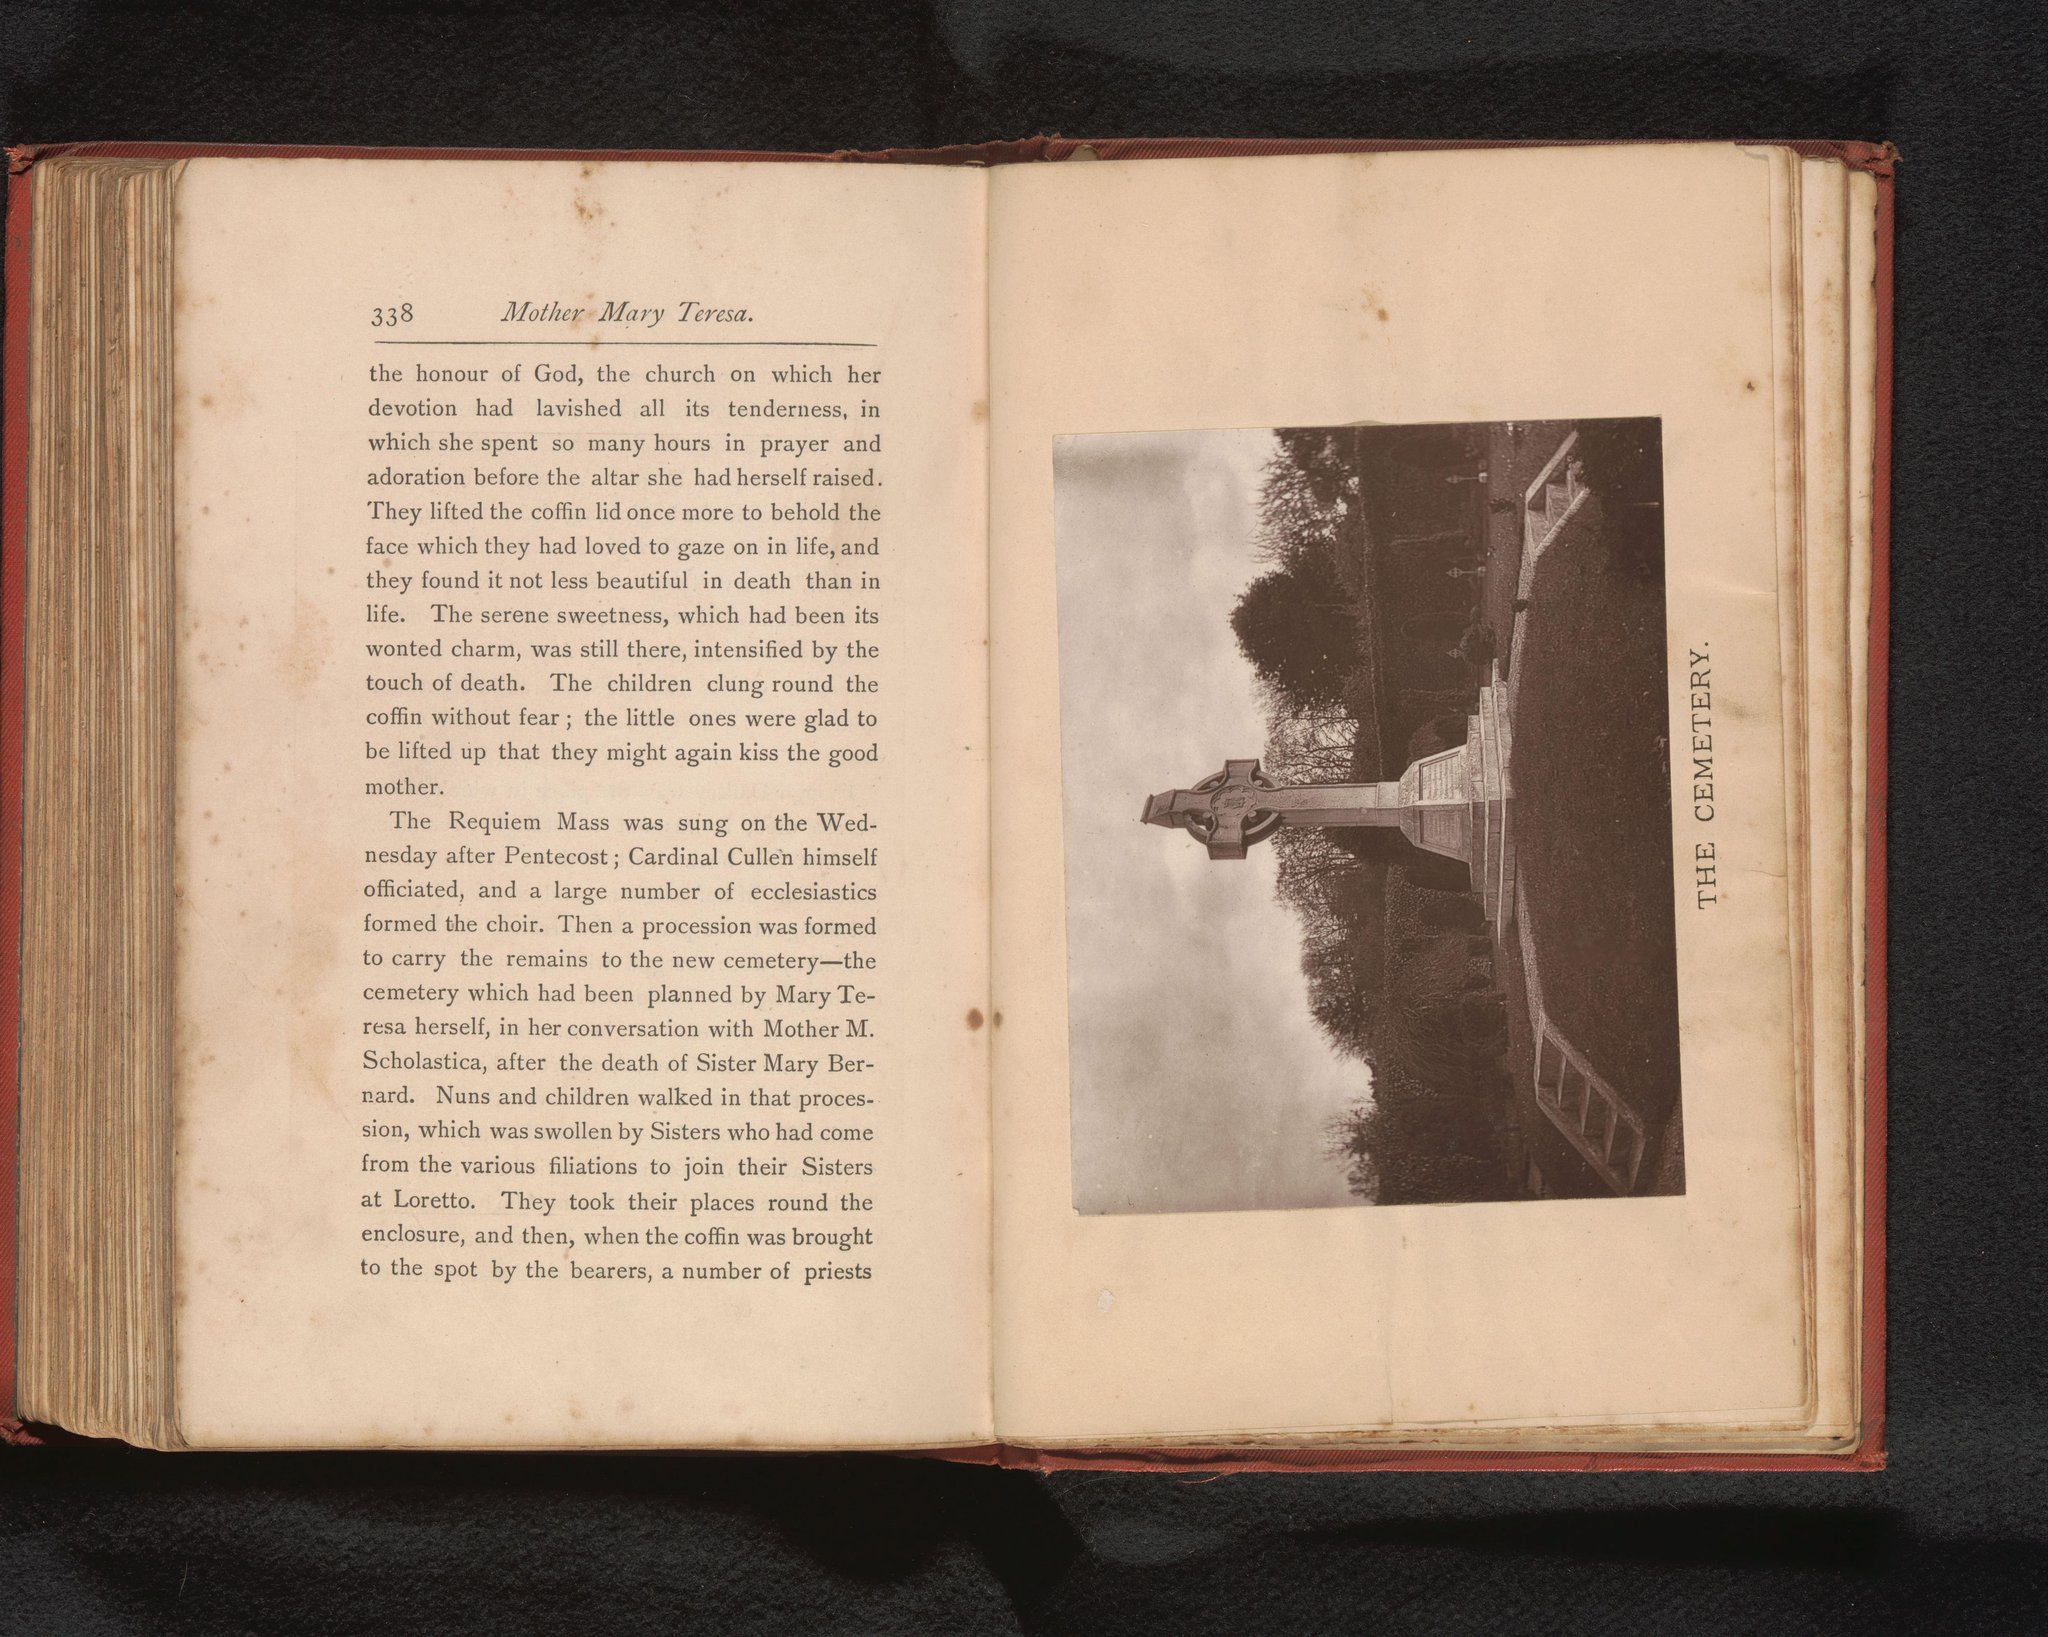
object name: page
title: The cemetery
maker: Anonymous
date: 1871-1881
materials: paper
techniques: woodburytype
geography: rathfarnham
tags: the cross ~ symbols of christ, abbey, monastery, convent ~ roman catholic church, churchyard, cemetery